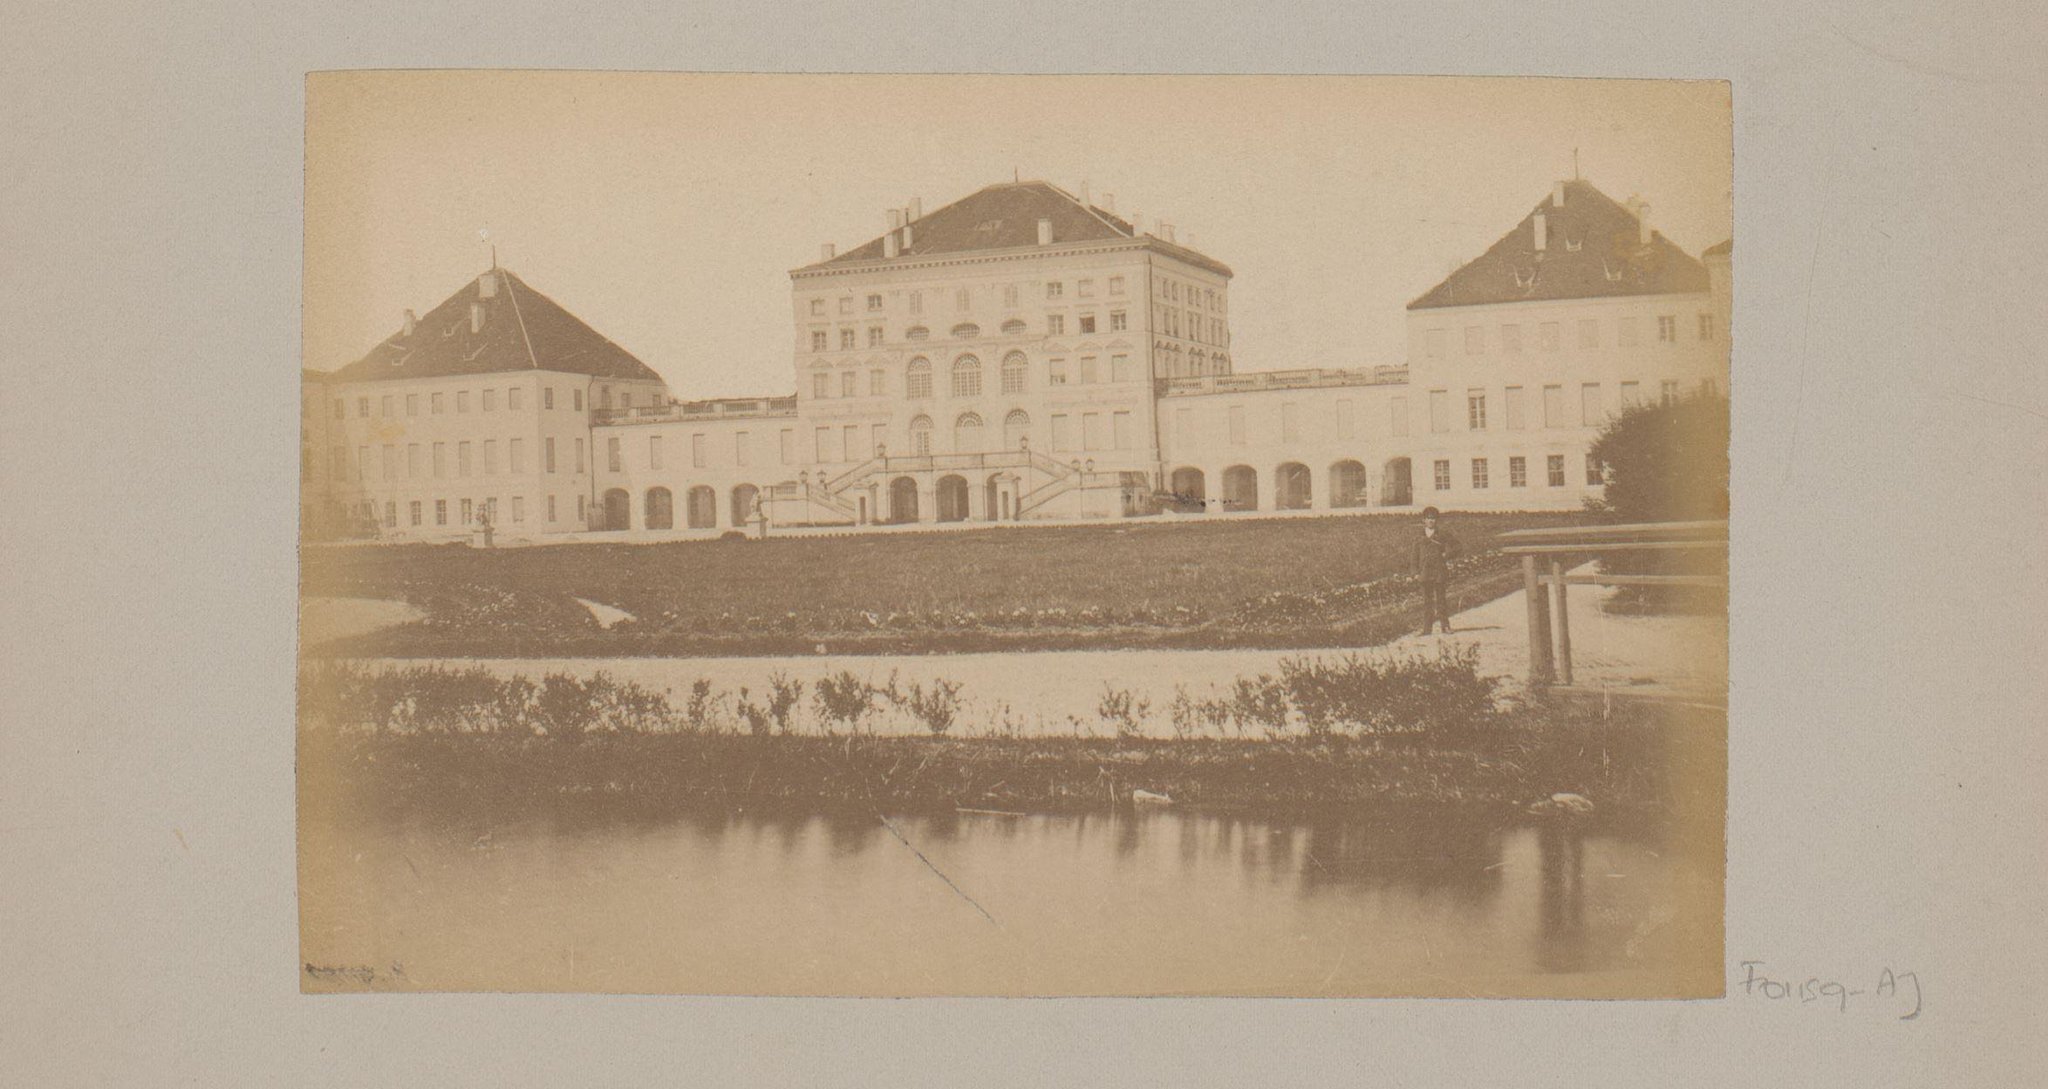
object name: photograph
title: Gezicht op Slot Nymphenburg in München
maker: Anonymous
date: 1880-1900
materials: photographic support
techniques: albumen print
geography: munich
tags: palace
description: Onderdeel van Reisalbum met opnames van bezienswaardigheden in Zweden, Noorwegen, Denemarken, Beieren, Milaan en Parijs.